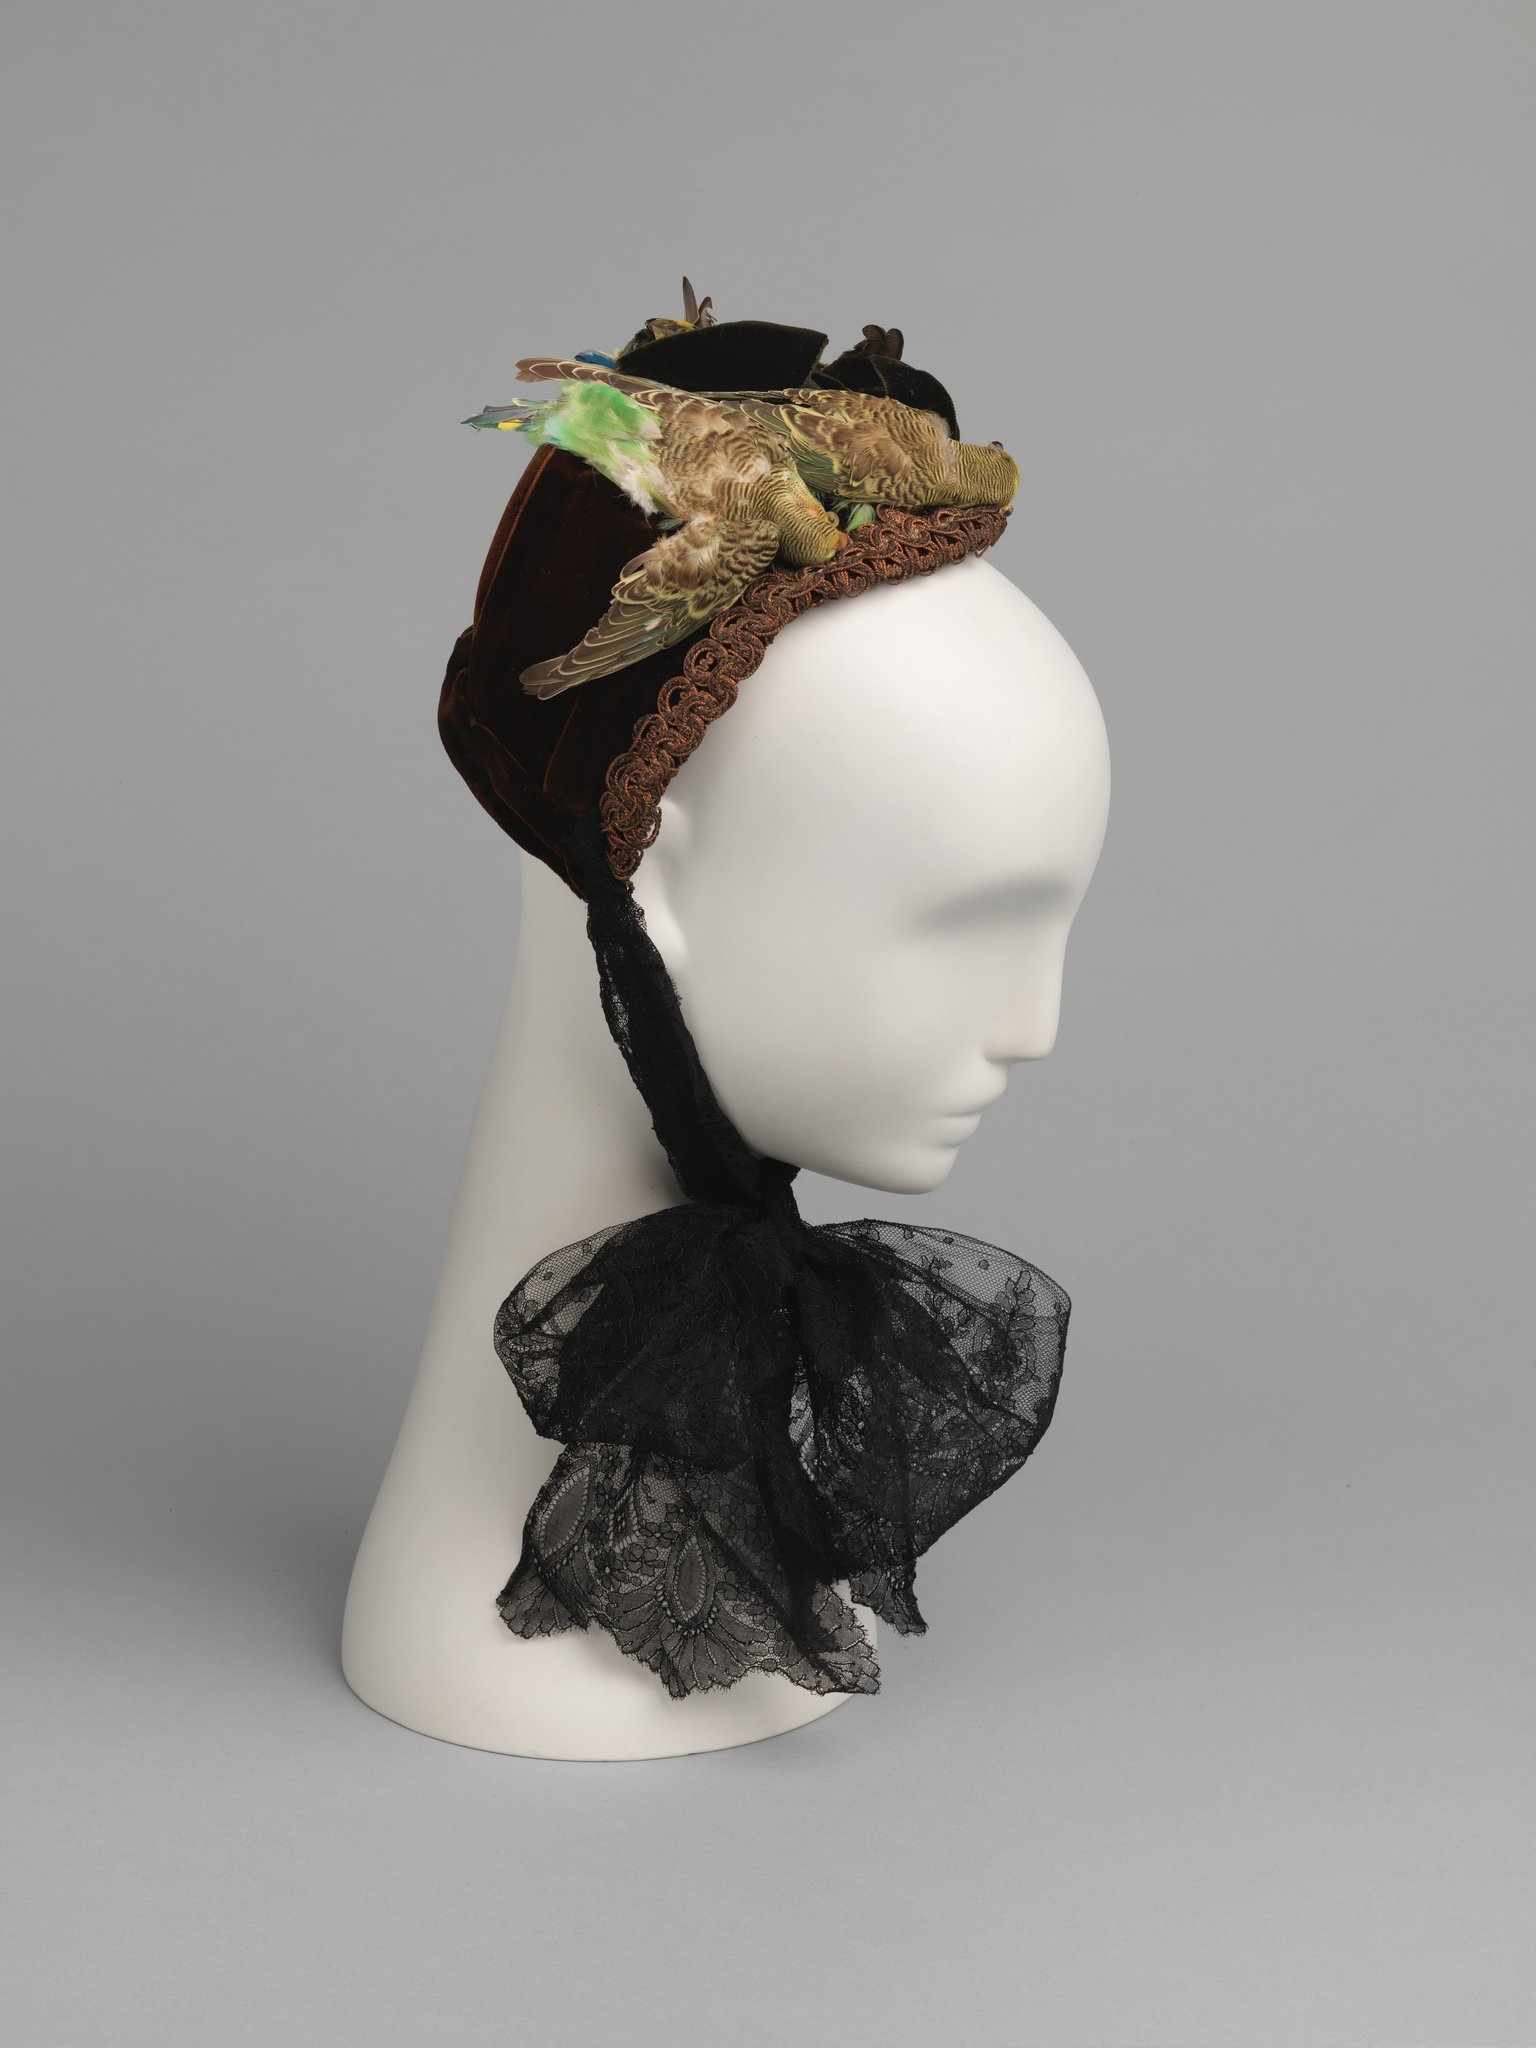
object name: bonnet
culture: american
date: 1890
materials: feather, silk